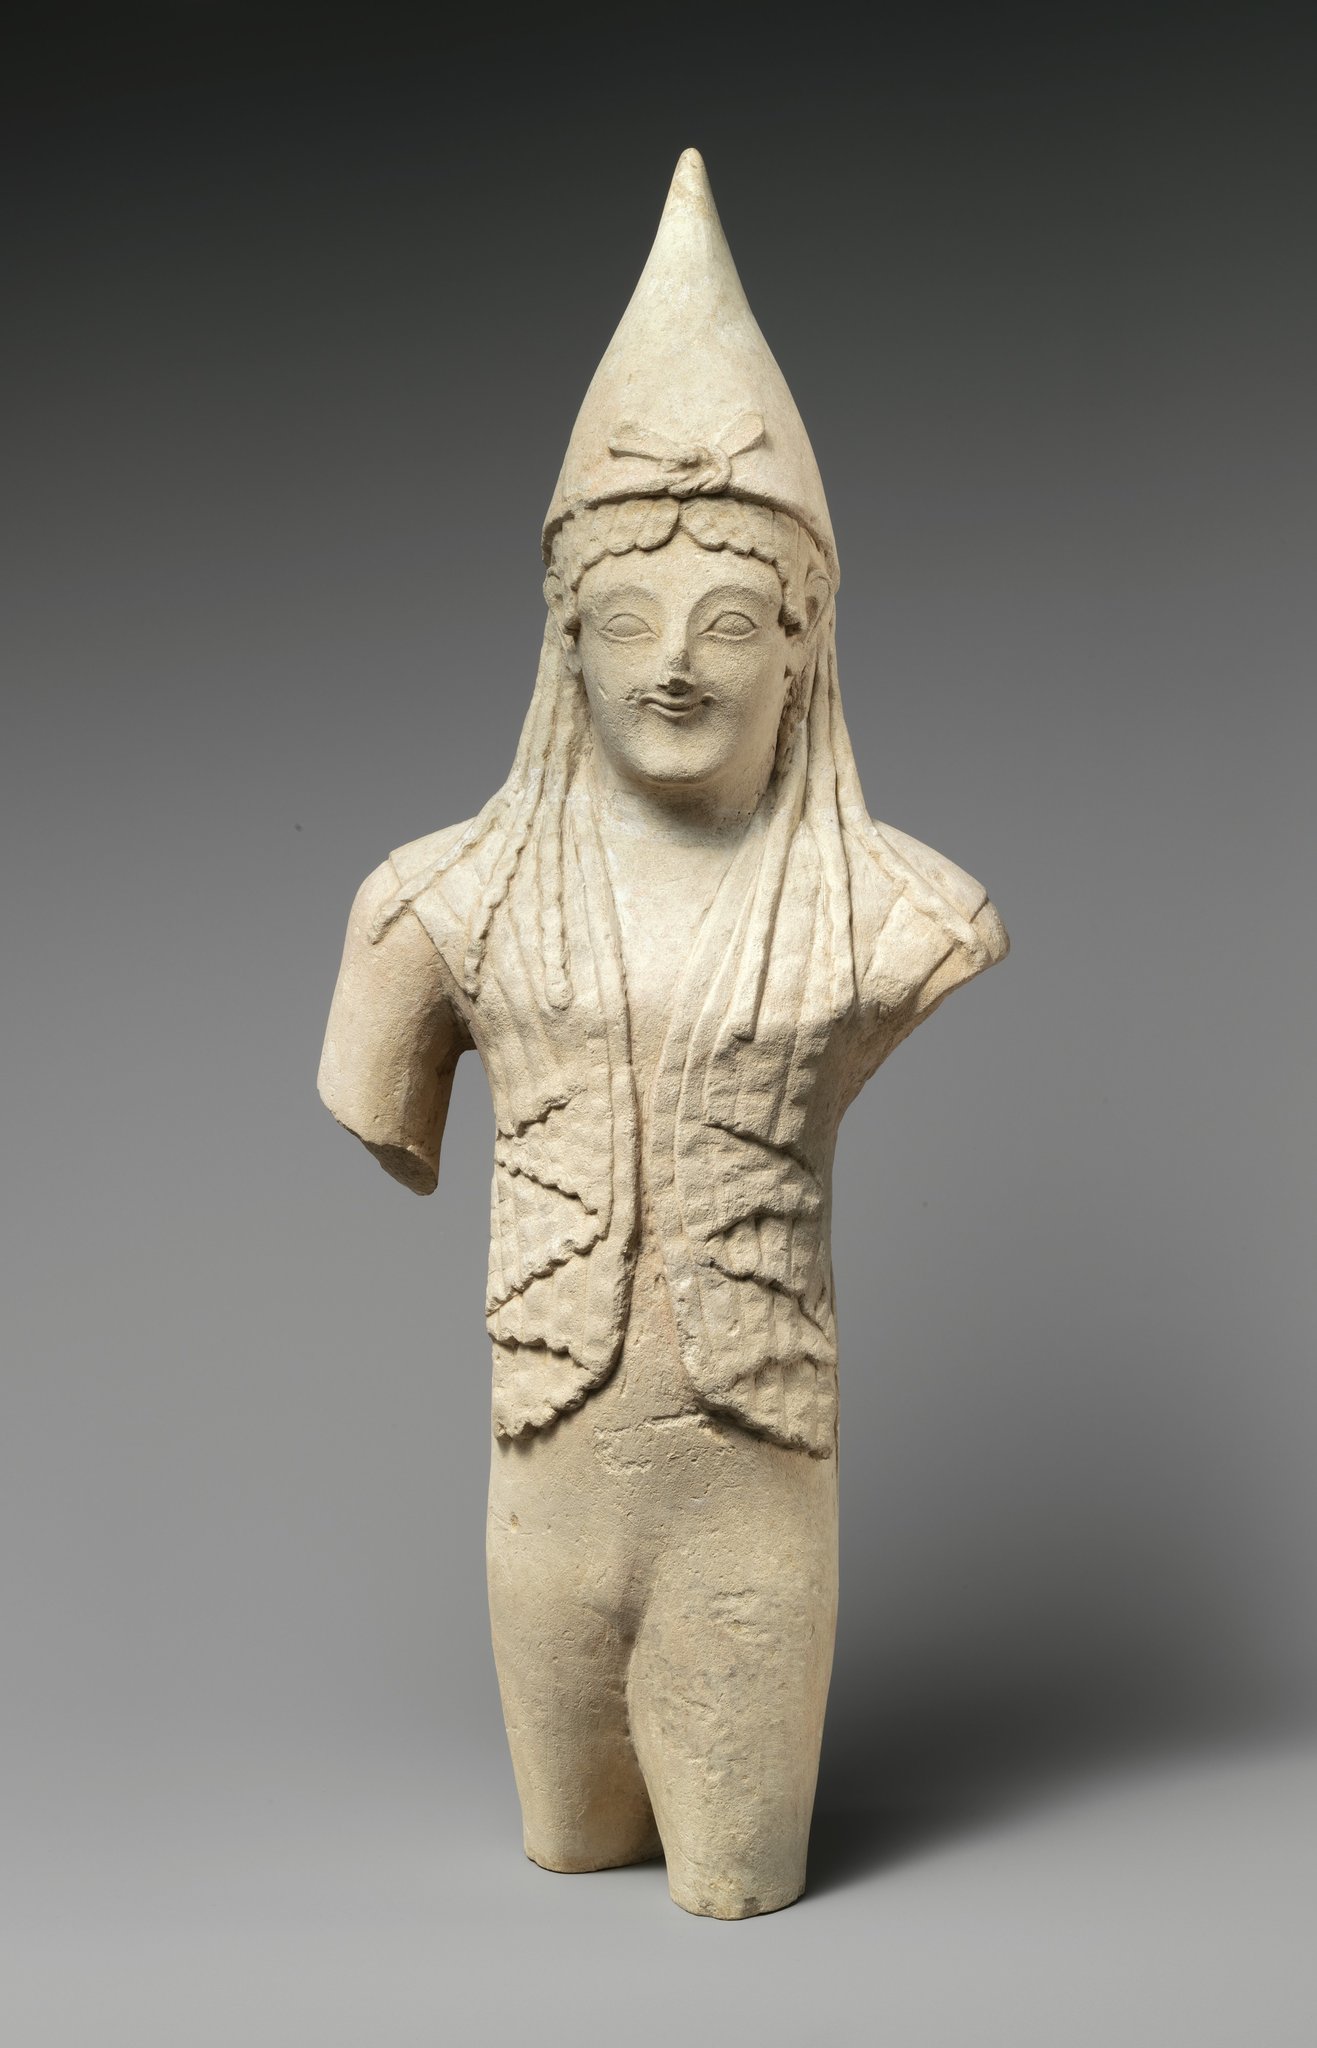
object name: statuette of a youthful votary wearing a pointed cap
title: Limestone statuette of a youthful votary wearing a pointed cap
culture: cypriot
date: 534-501 BCE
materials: limestone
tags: men